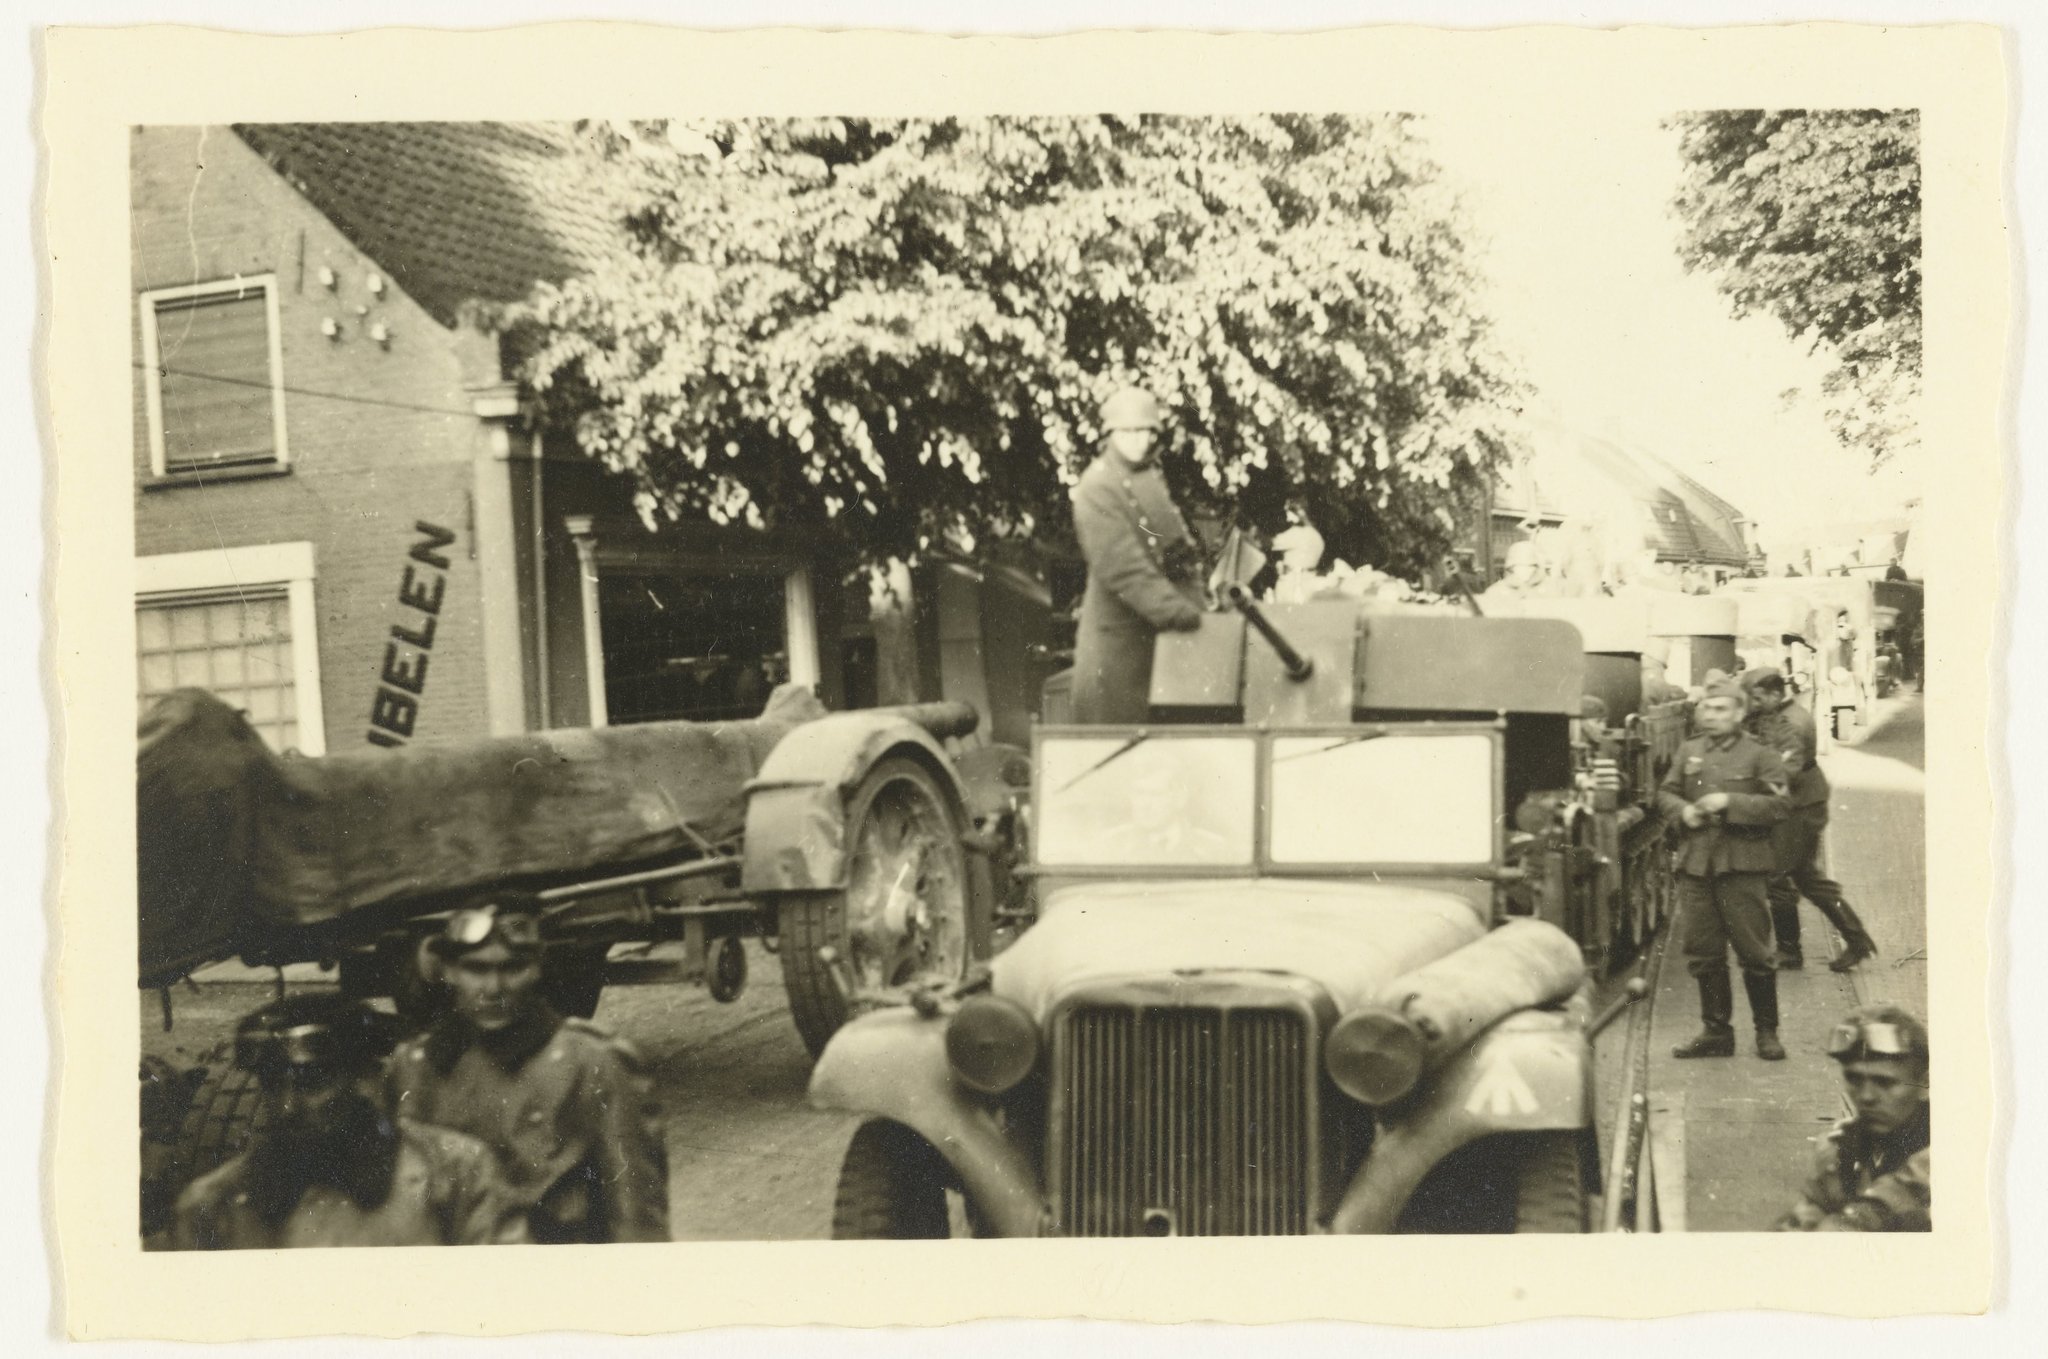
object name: photograph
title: Wehrmacht trekt door Nederland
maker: Anonymous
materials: photographic support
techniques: gelatin silver print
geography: netherlands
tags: troop movements, transportation, occupation ~ war, netherlands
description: De Wehrmacht trekt met pantserwagens een Nederlandse stad of dorp binnen. Voorop een auto met geschut, ernaast ingepakt geschut. Aan de bomen te zien is het voorjaar.